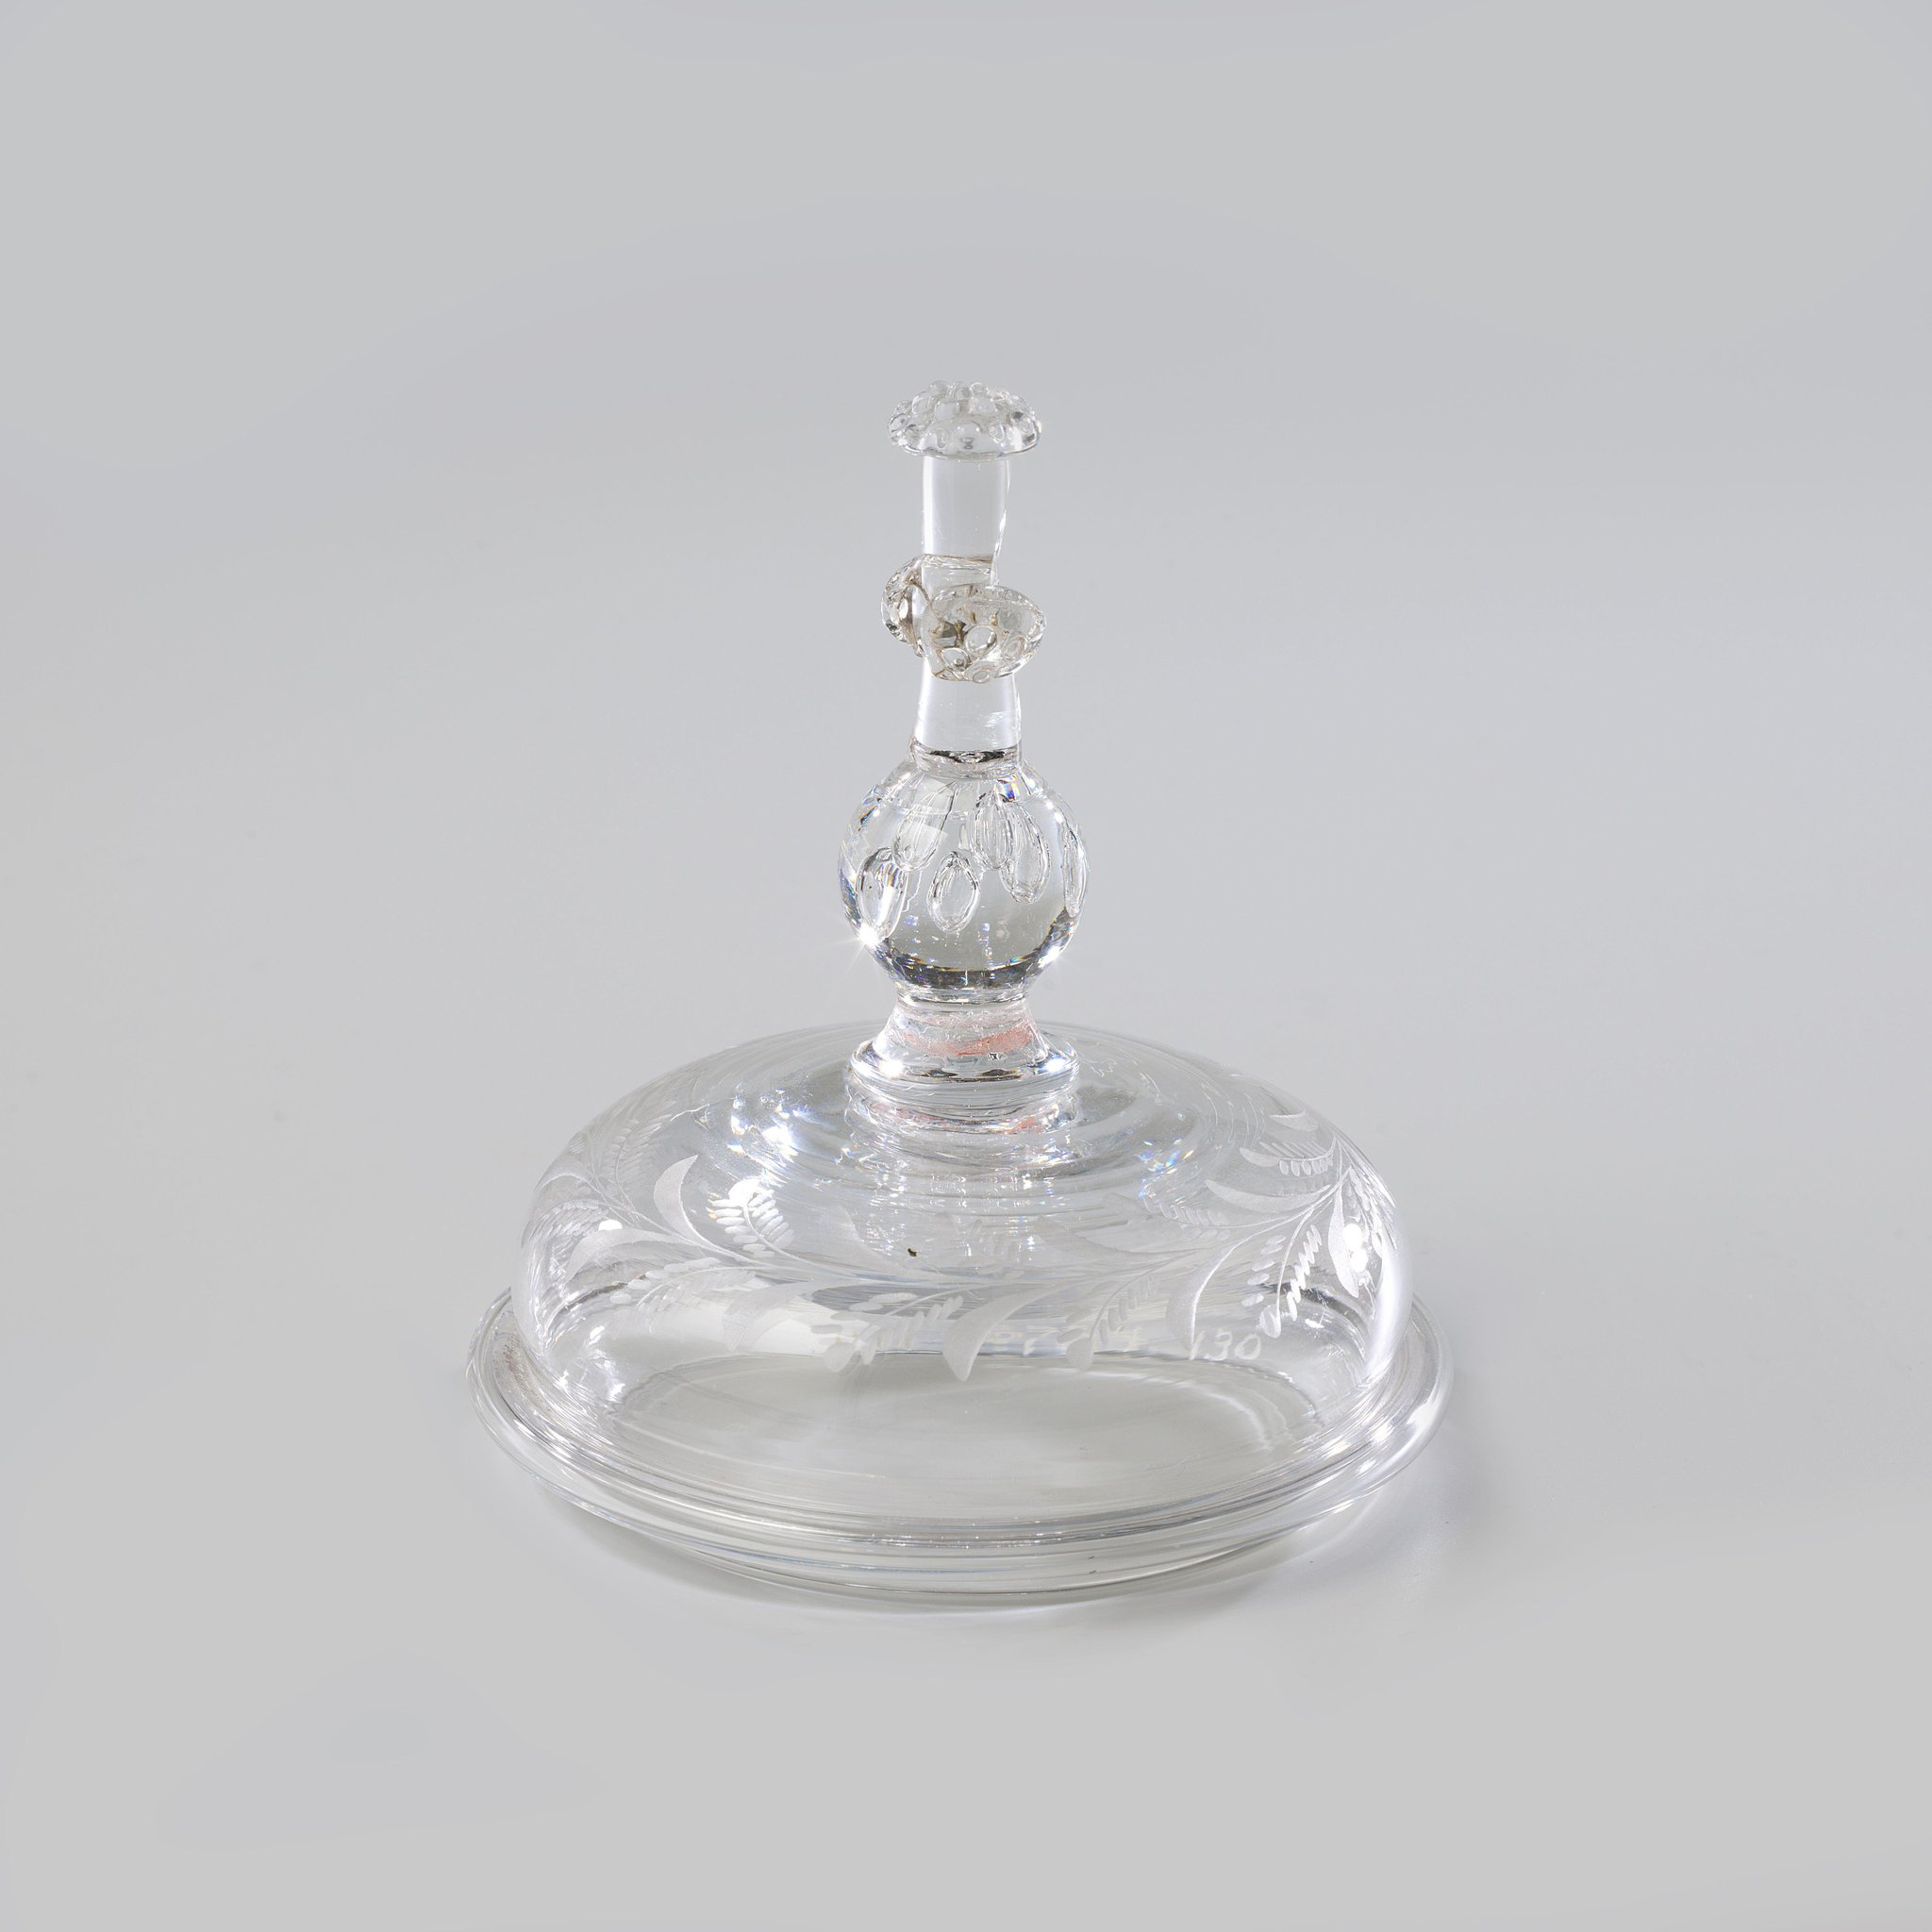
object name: lid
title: Deksel van een bokaal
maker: Anonymous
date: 1750-1775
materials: glass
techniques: glassblowing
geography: netherlands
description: Gewelfde deksel, bekroond met gelede dekselknop, bestaande uit een bolvormige knop met een rij luchtbellen en een staafvormig uiteinde met drie braamnoppen. Op de deksel een gegraveerd bladslinger.